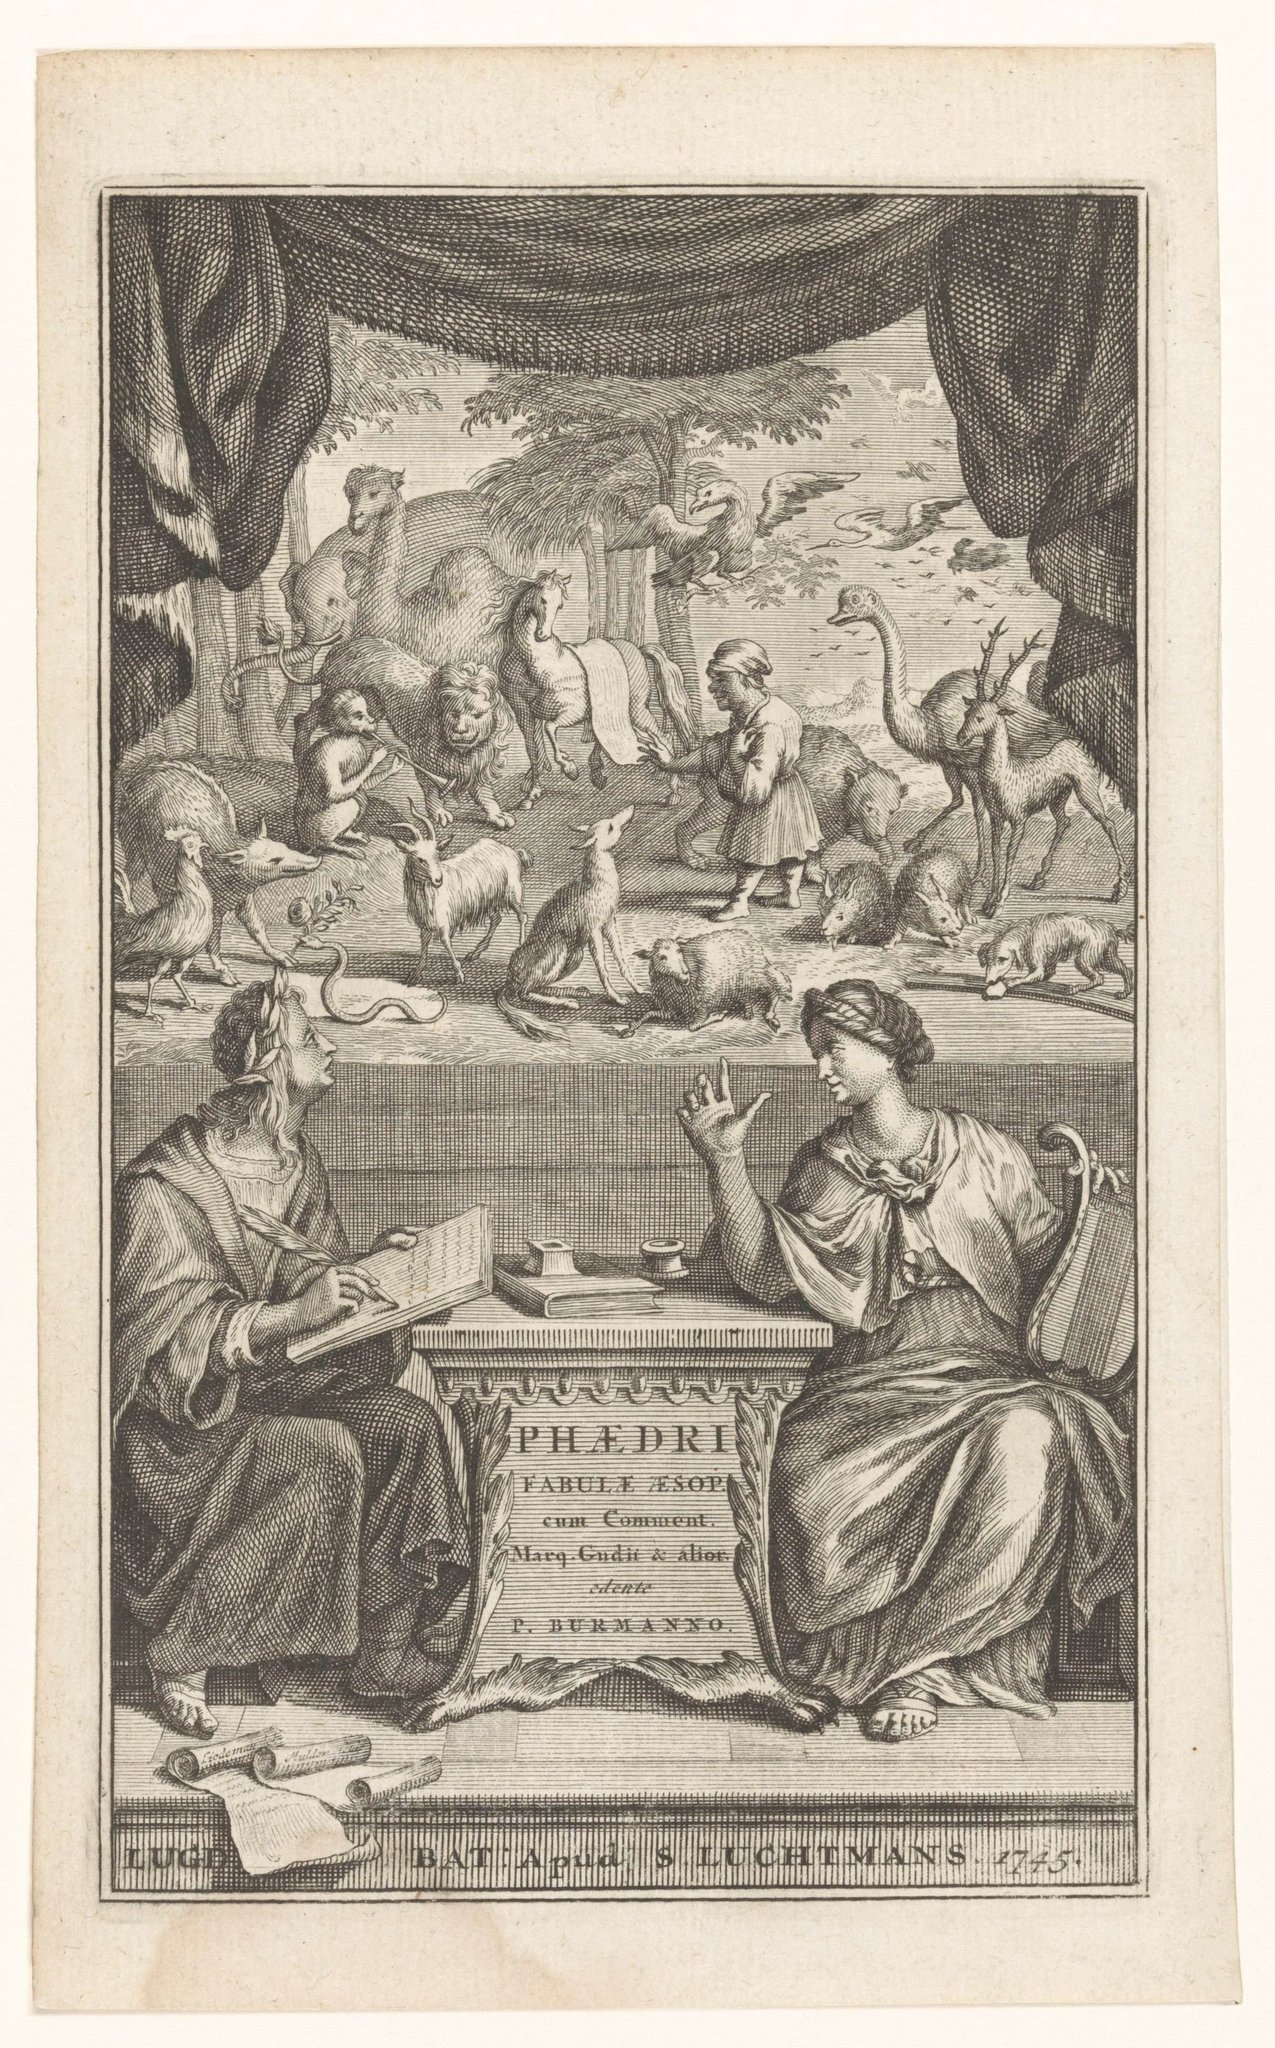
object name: titelblad, titelpagina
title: Titelpagina voor: Pieter Burman, Phaedri fabulae Aesop, 1745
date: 1745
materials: paper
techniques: engraving, etching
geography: leiden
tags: fables of aesop : use 85(...), writer, poet, author, terpsichore (one of the muses); 'terpsicore' (ripa)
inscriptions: collector's mark: Lugt 2760, collector's mark: Lugt 2228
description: Bij een stenen tafel met boektitel schrijft een man, mogelijk Aesopus, op een tablet. Tegenover hem zit een vrouw met lier, mogelijk de muze Terpsichore. In de achtergrond op een toneel de dieren en een kleine mens die voorkomen in de fabels van Aesopus.